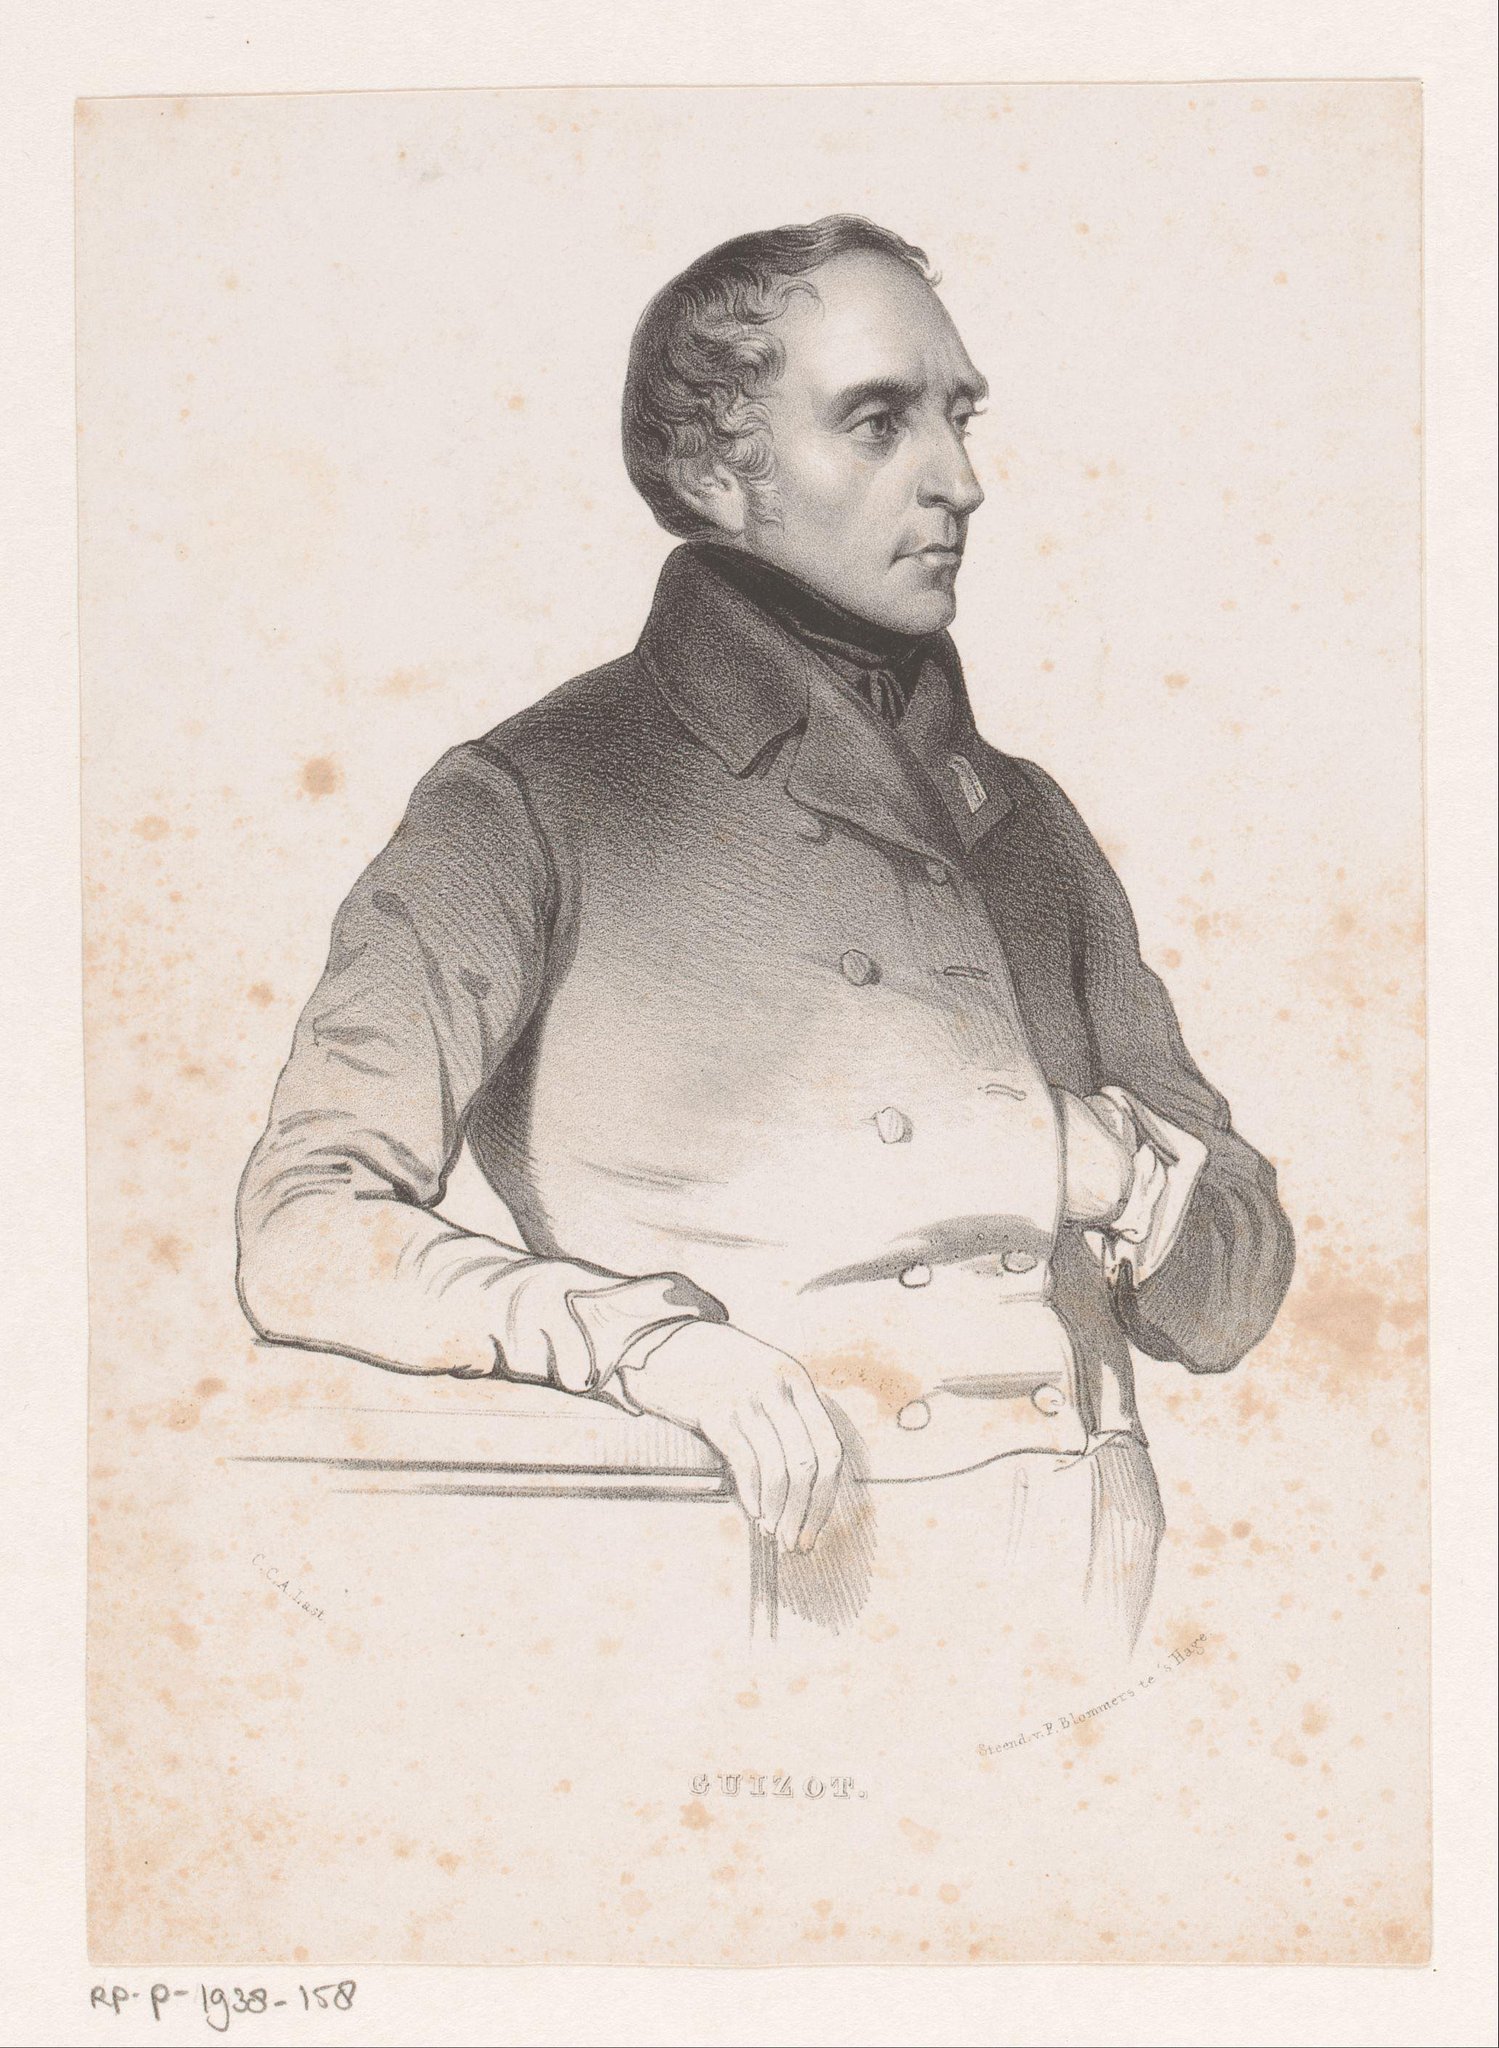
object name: print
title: Portret van François Guizot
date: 1842-1887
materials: paper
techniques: lithograph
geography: the hague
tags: hand on breast (or stomach), slipped into opening of vestment, historical persons (+ half-length portrait)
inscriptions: collector's mark: Lugt 2228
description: Vibert maakte het schilderij naar een schilderij van Paul Delaroche, gedateerd circa 1839. Het schilderij van Vibert bevindt zich in het Chateau de Versailles. Het schilderij van Delaroche in de Ny Carlsberg Glyptotek in Kopenhagen.